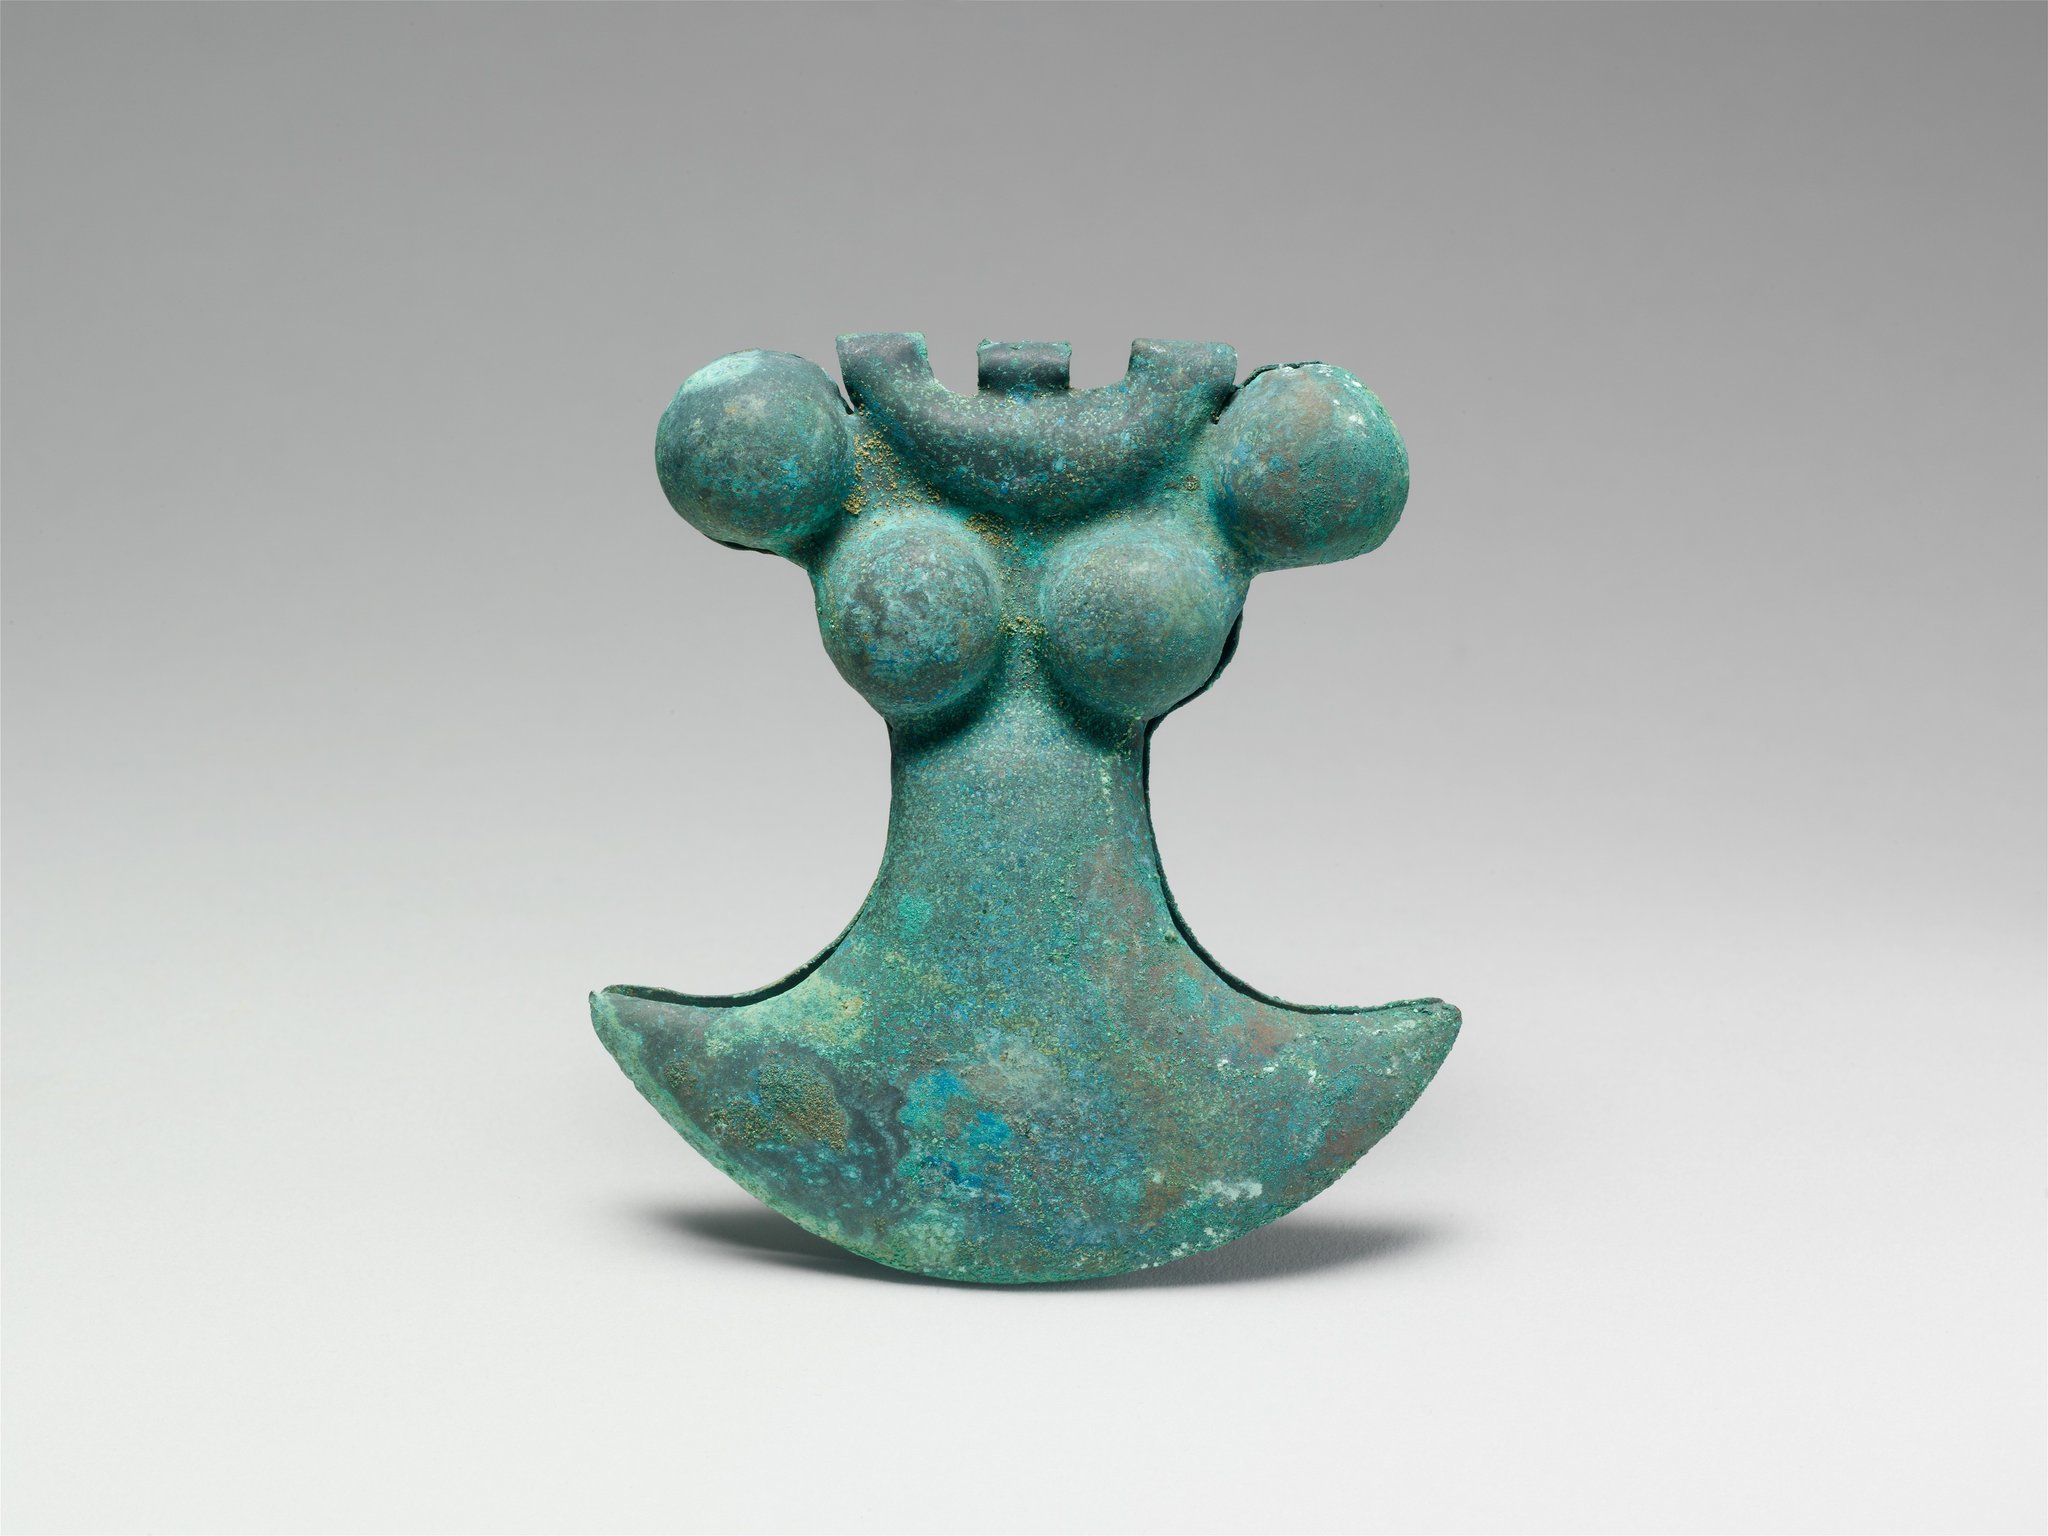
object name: ornament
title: Belt Ornament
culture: moche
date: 101-700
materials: copper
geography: peru